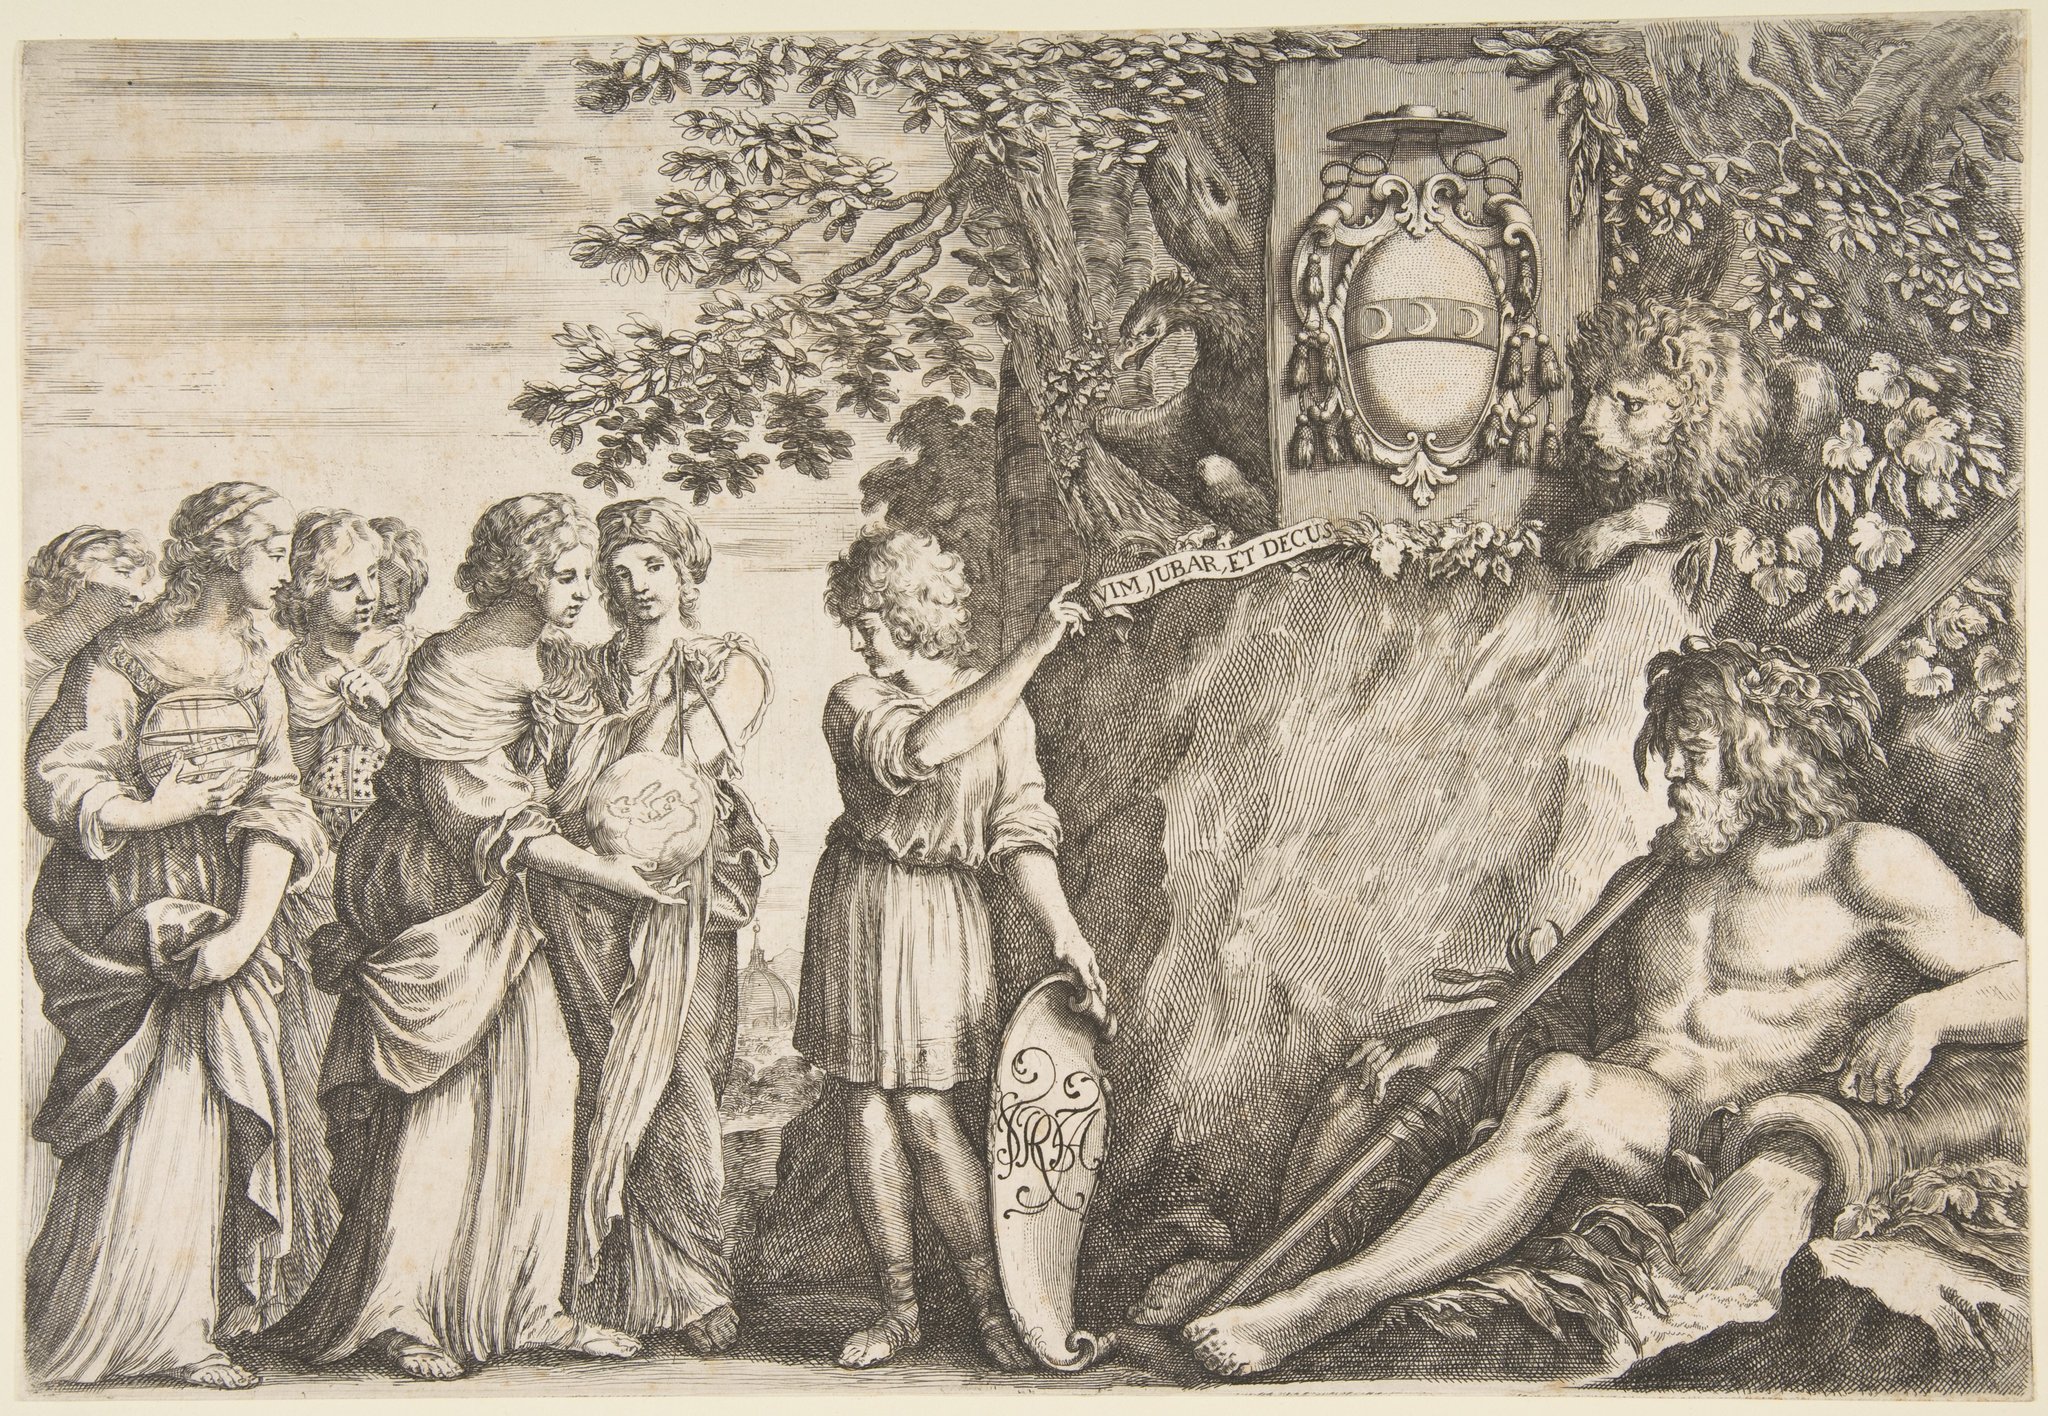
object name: print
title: Ornament design for a thesis, the Strozzi coat of arms at top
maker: stefano della bella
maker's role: artist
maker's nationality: italian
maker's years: 1610-1664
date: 1660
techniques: engraving, etching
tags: eagles,men,women,lions,coat of arms